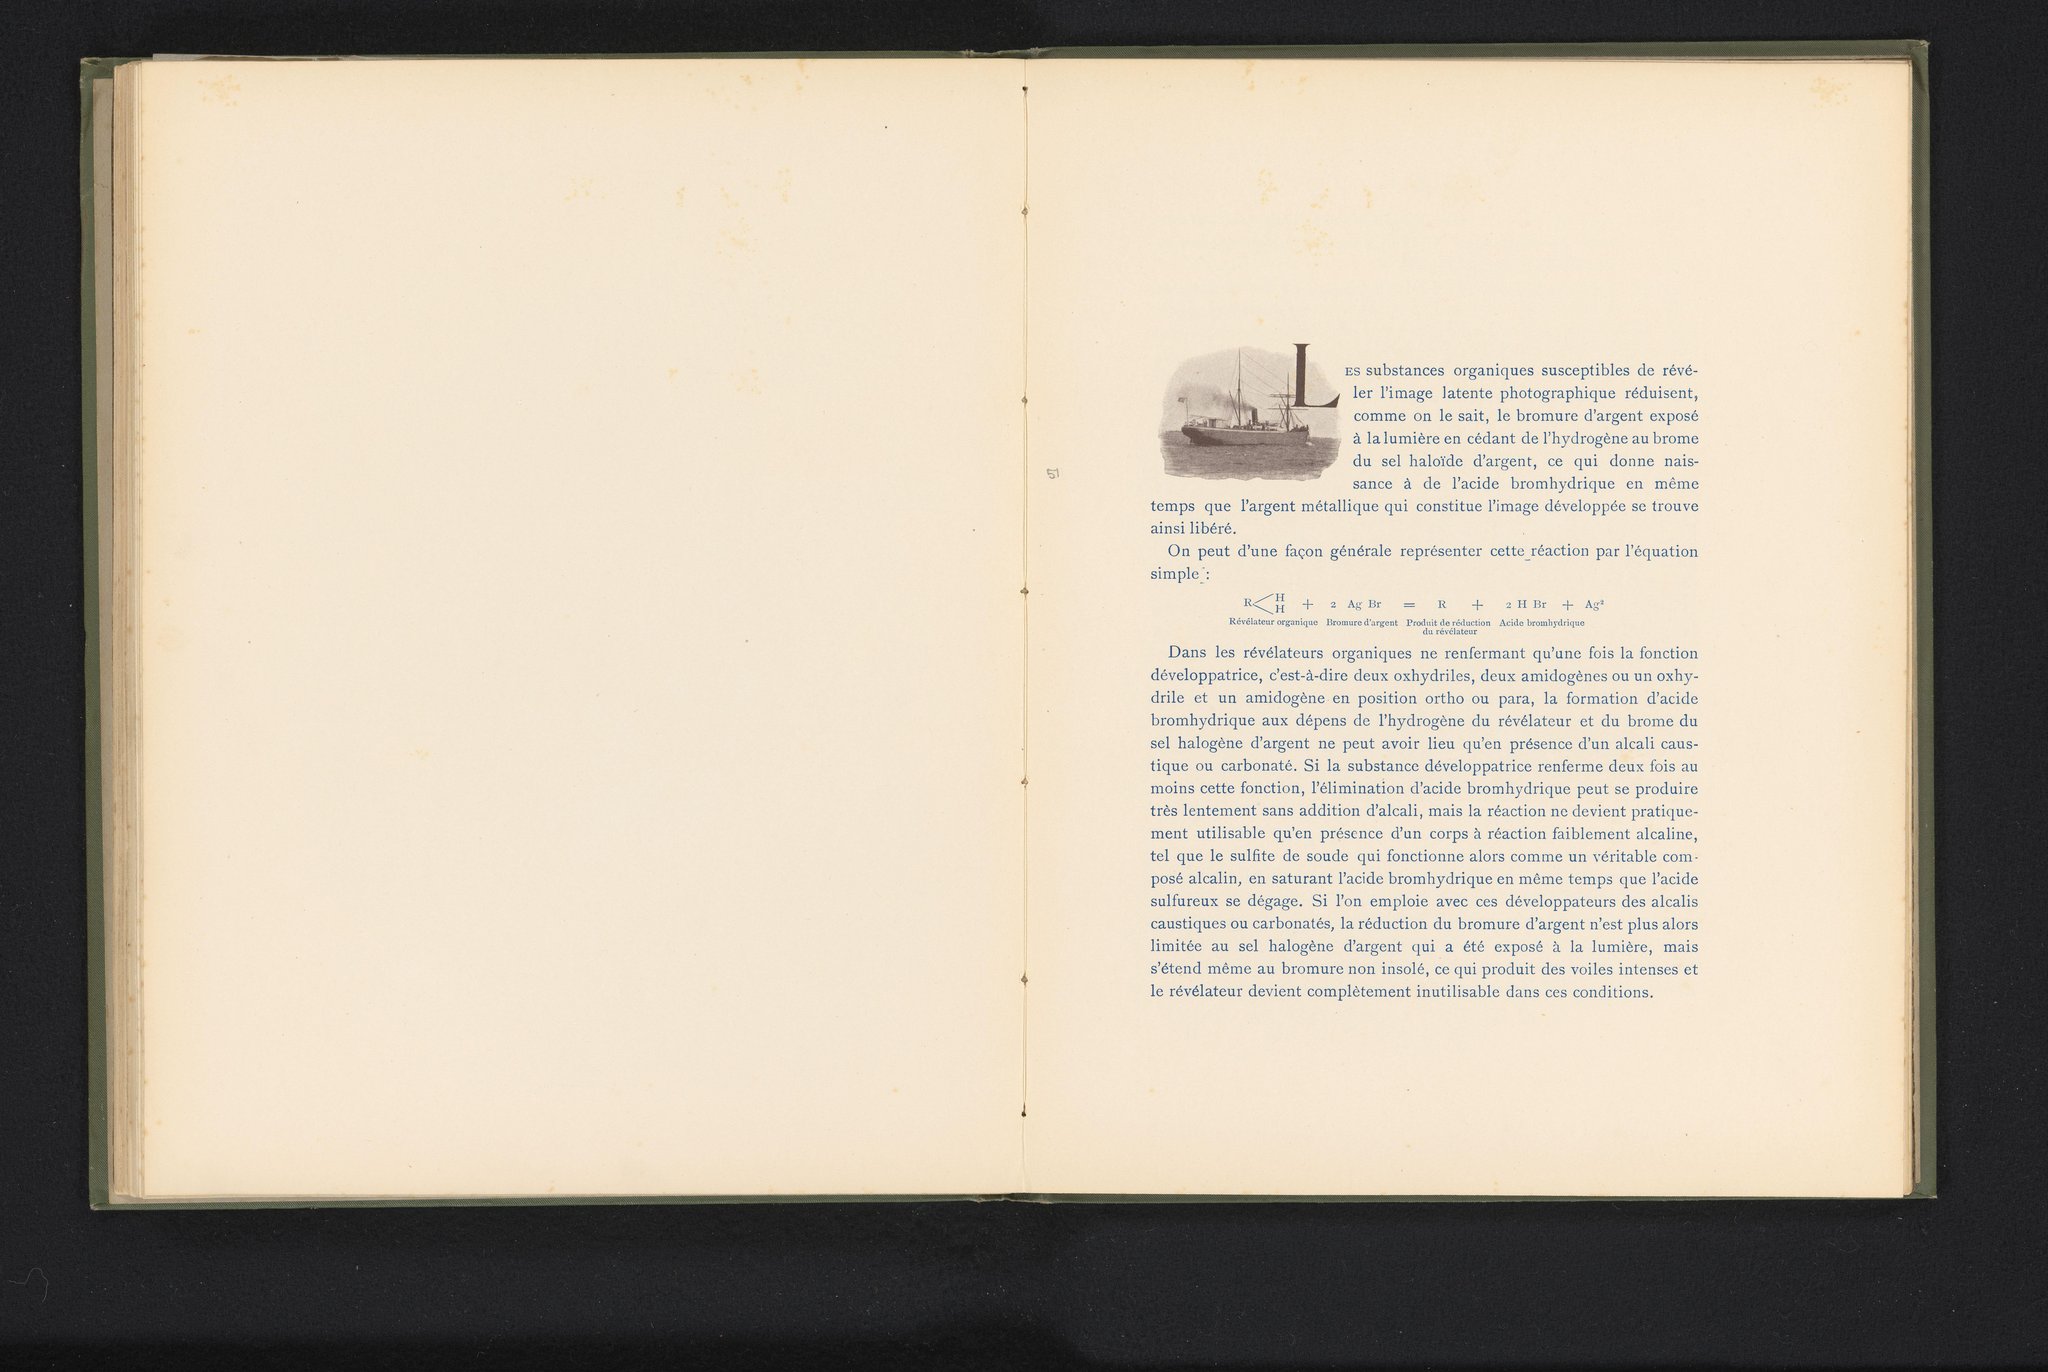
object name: photomechanical print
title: Stoomboot op zee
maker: Anonymous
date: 1893-1898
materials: paper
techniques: autotype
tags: steamship, motorship, sea